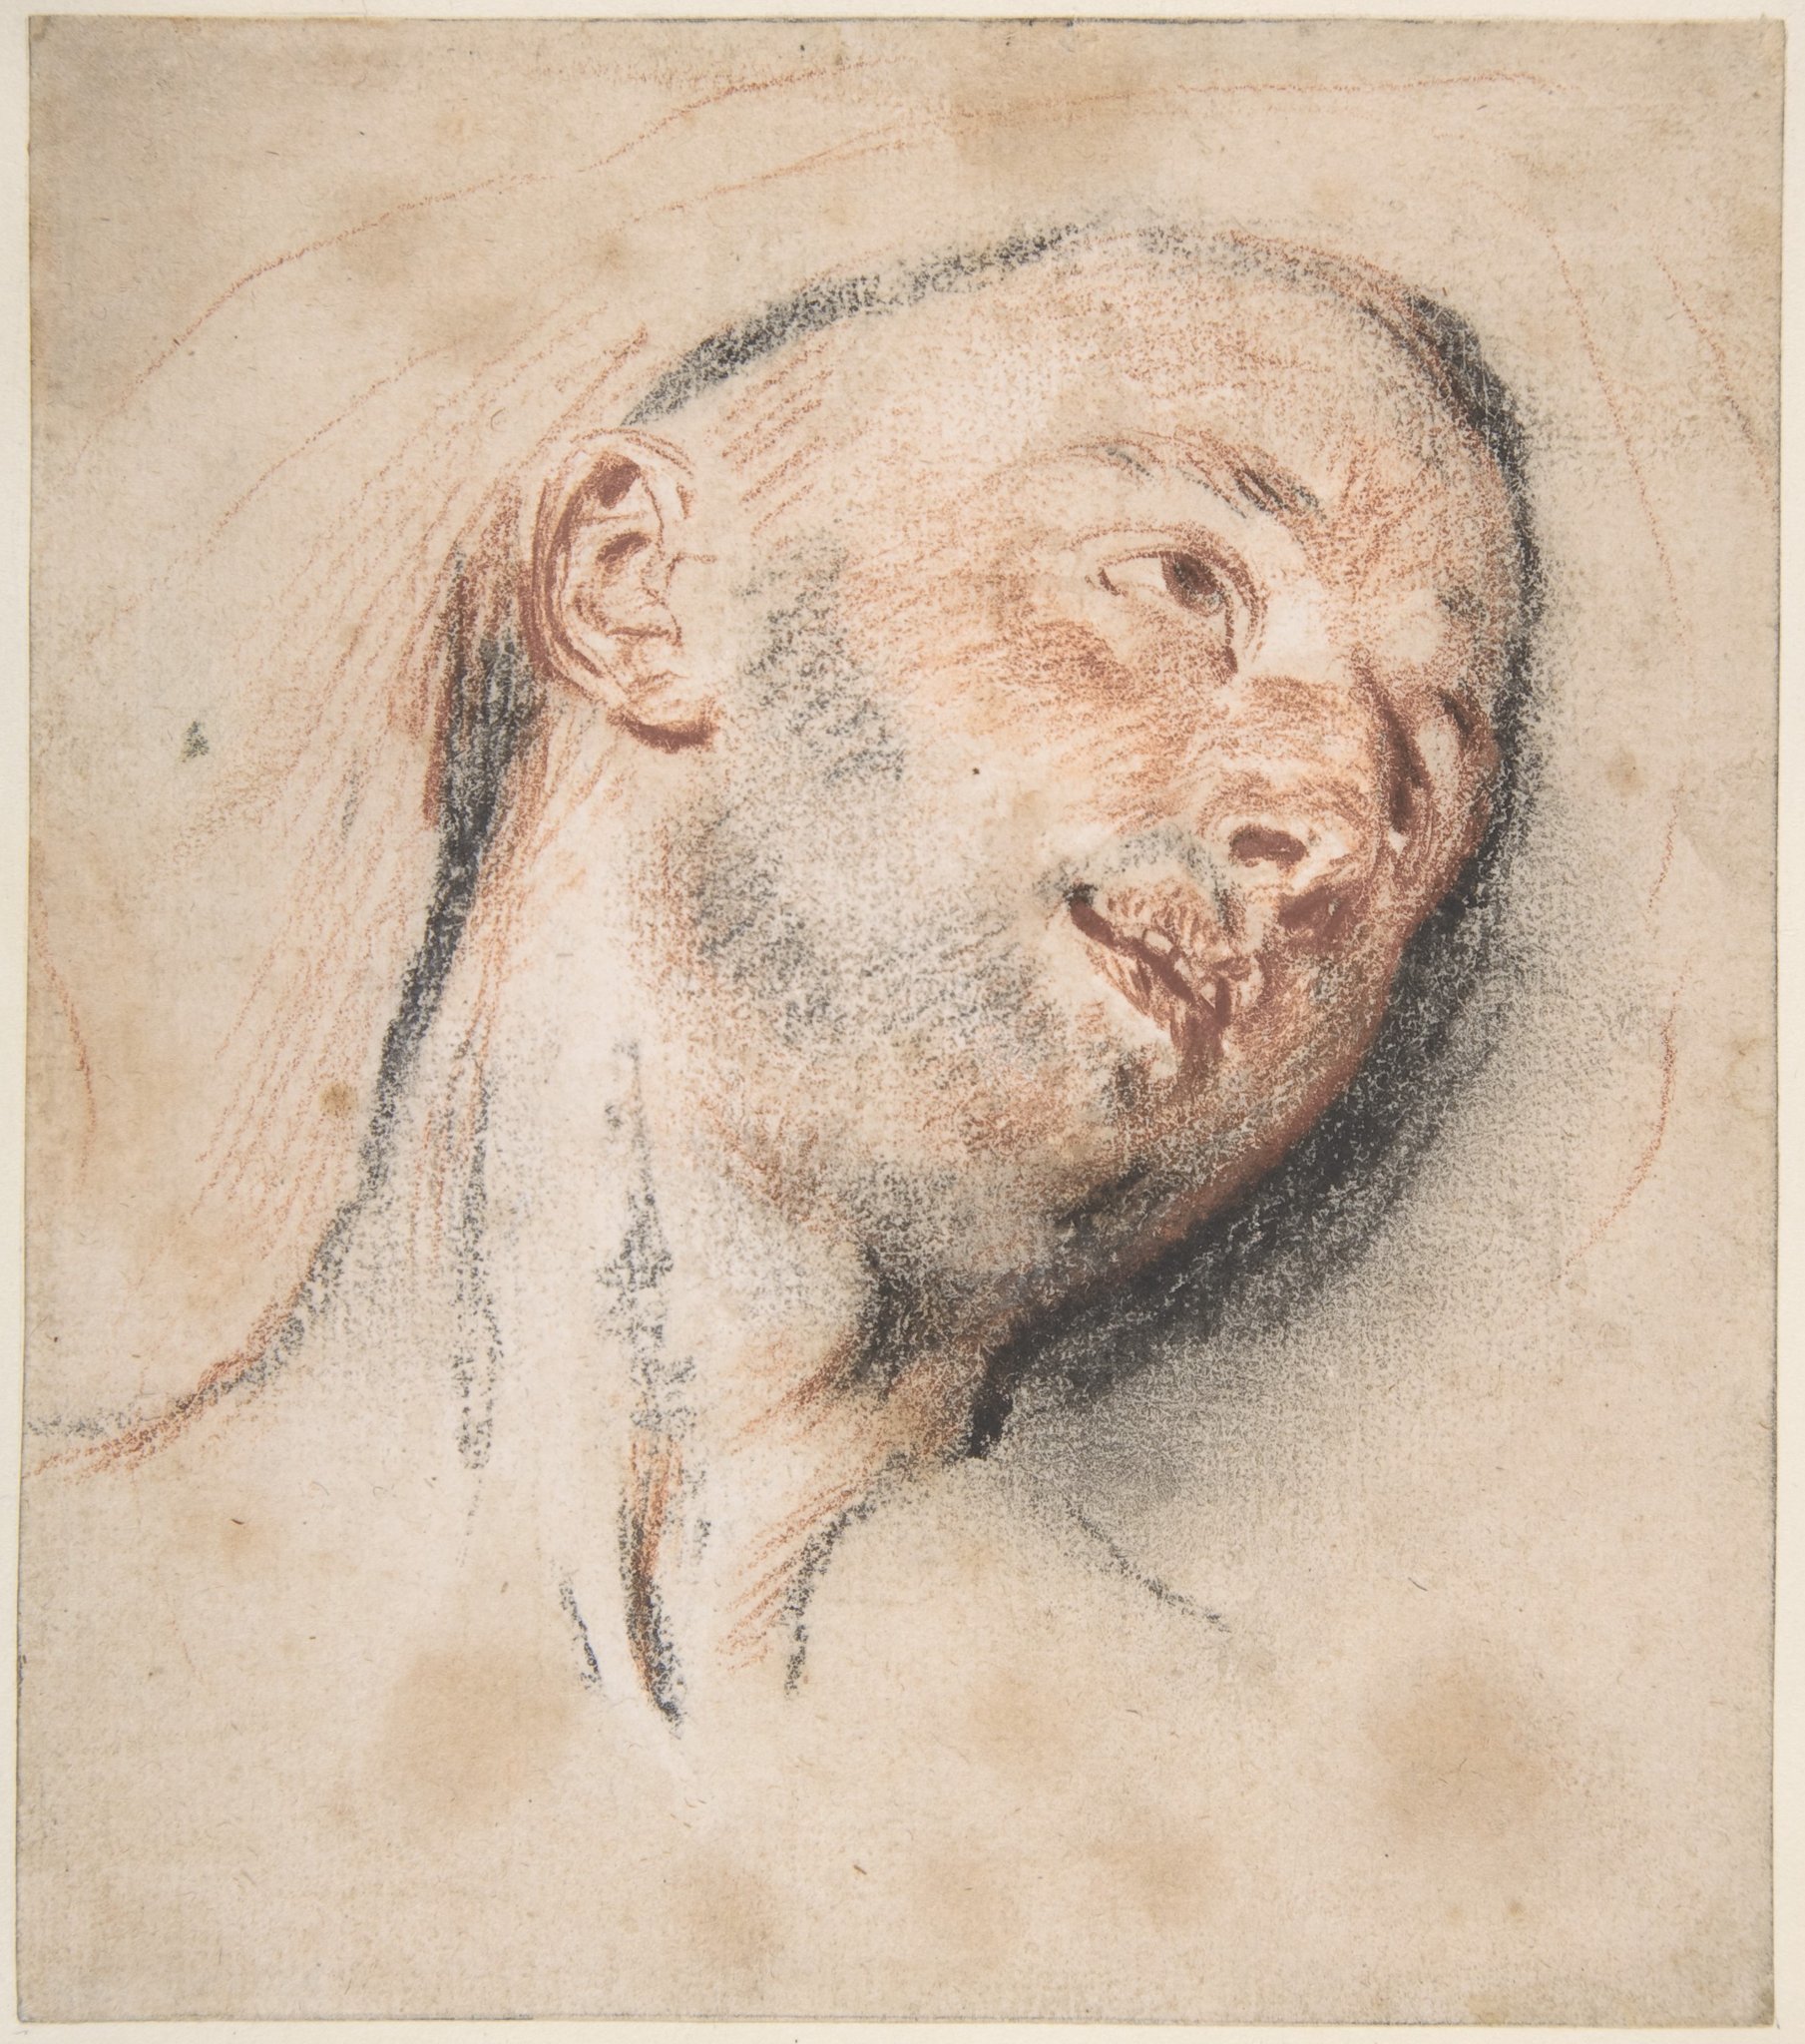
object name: drawing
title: Head of a Man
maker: antoine watteau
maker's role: artist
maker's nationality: french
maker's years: 1684-1721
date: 1718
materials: chalk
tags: heads,men